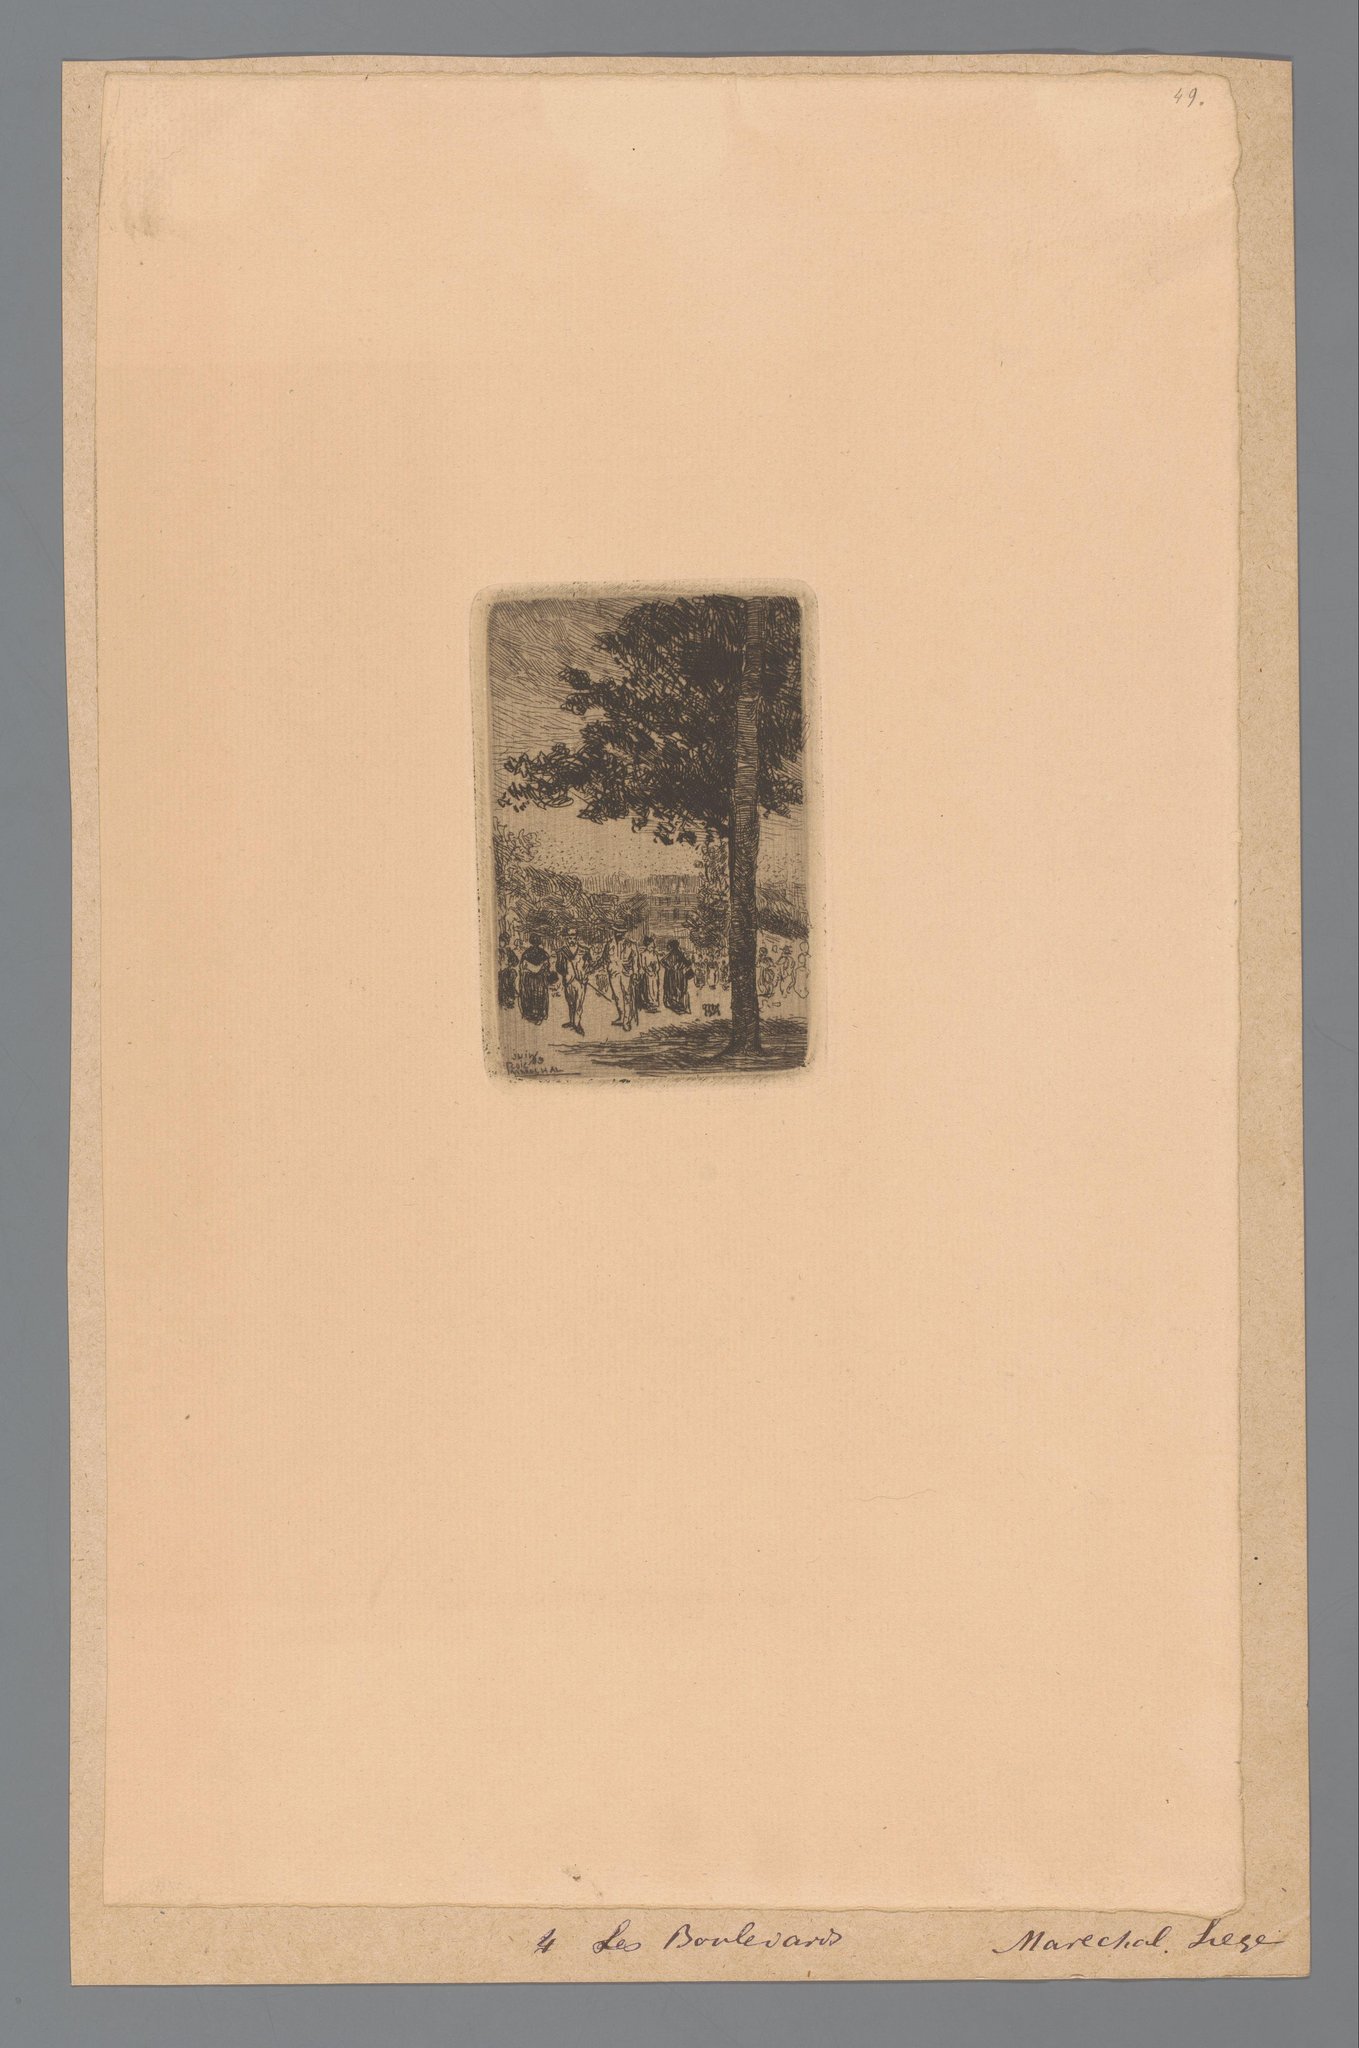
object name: print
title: Gezicht op een boulevard met rechts een boom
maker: françois maréchal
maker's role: print maker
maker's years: 1861-1945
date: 1889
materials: paper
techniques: etching, intaglio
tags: trees, avenue, boulevard, promenade, esplanade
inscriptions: collector's mark: Lugt 2228